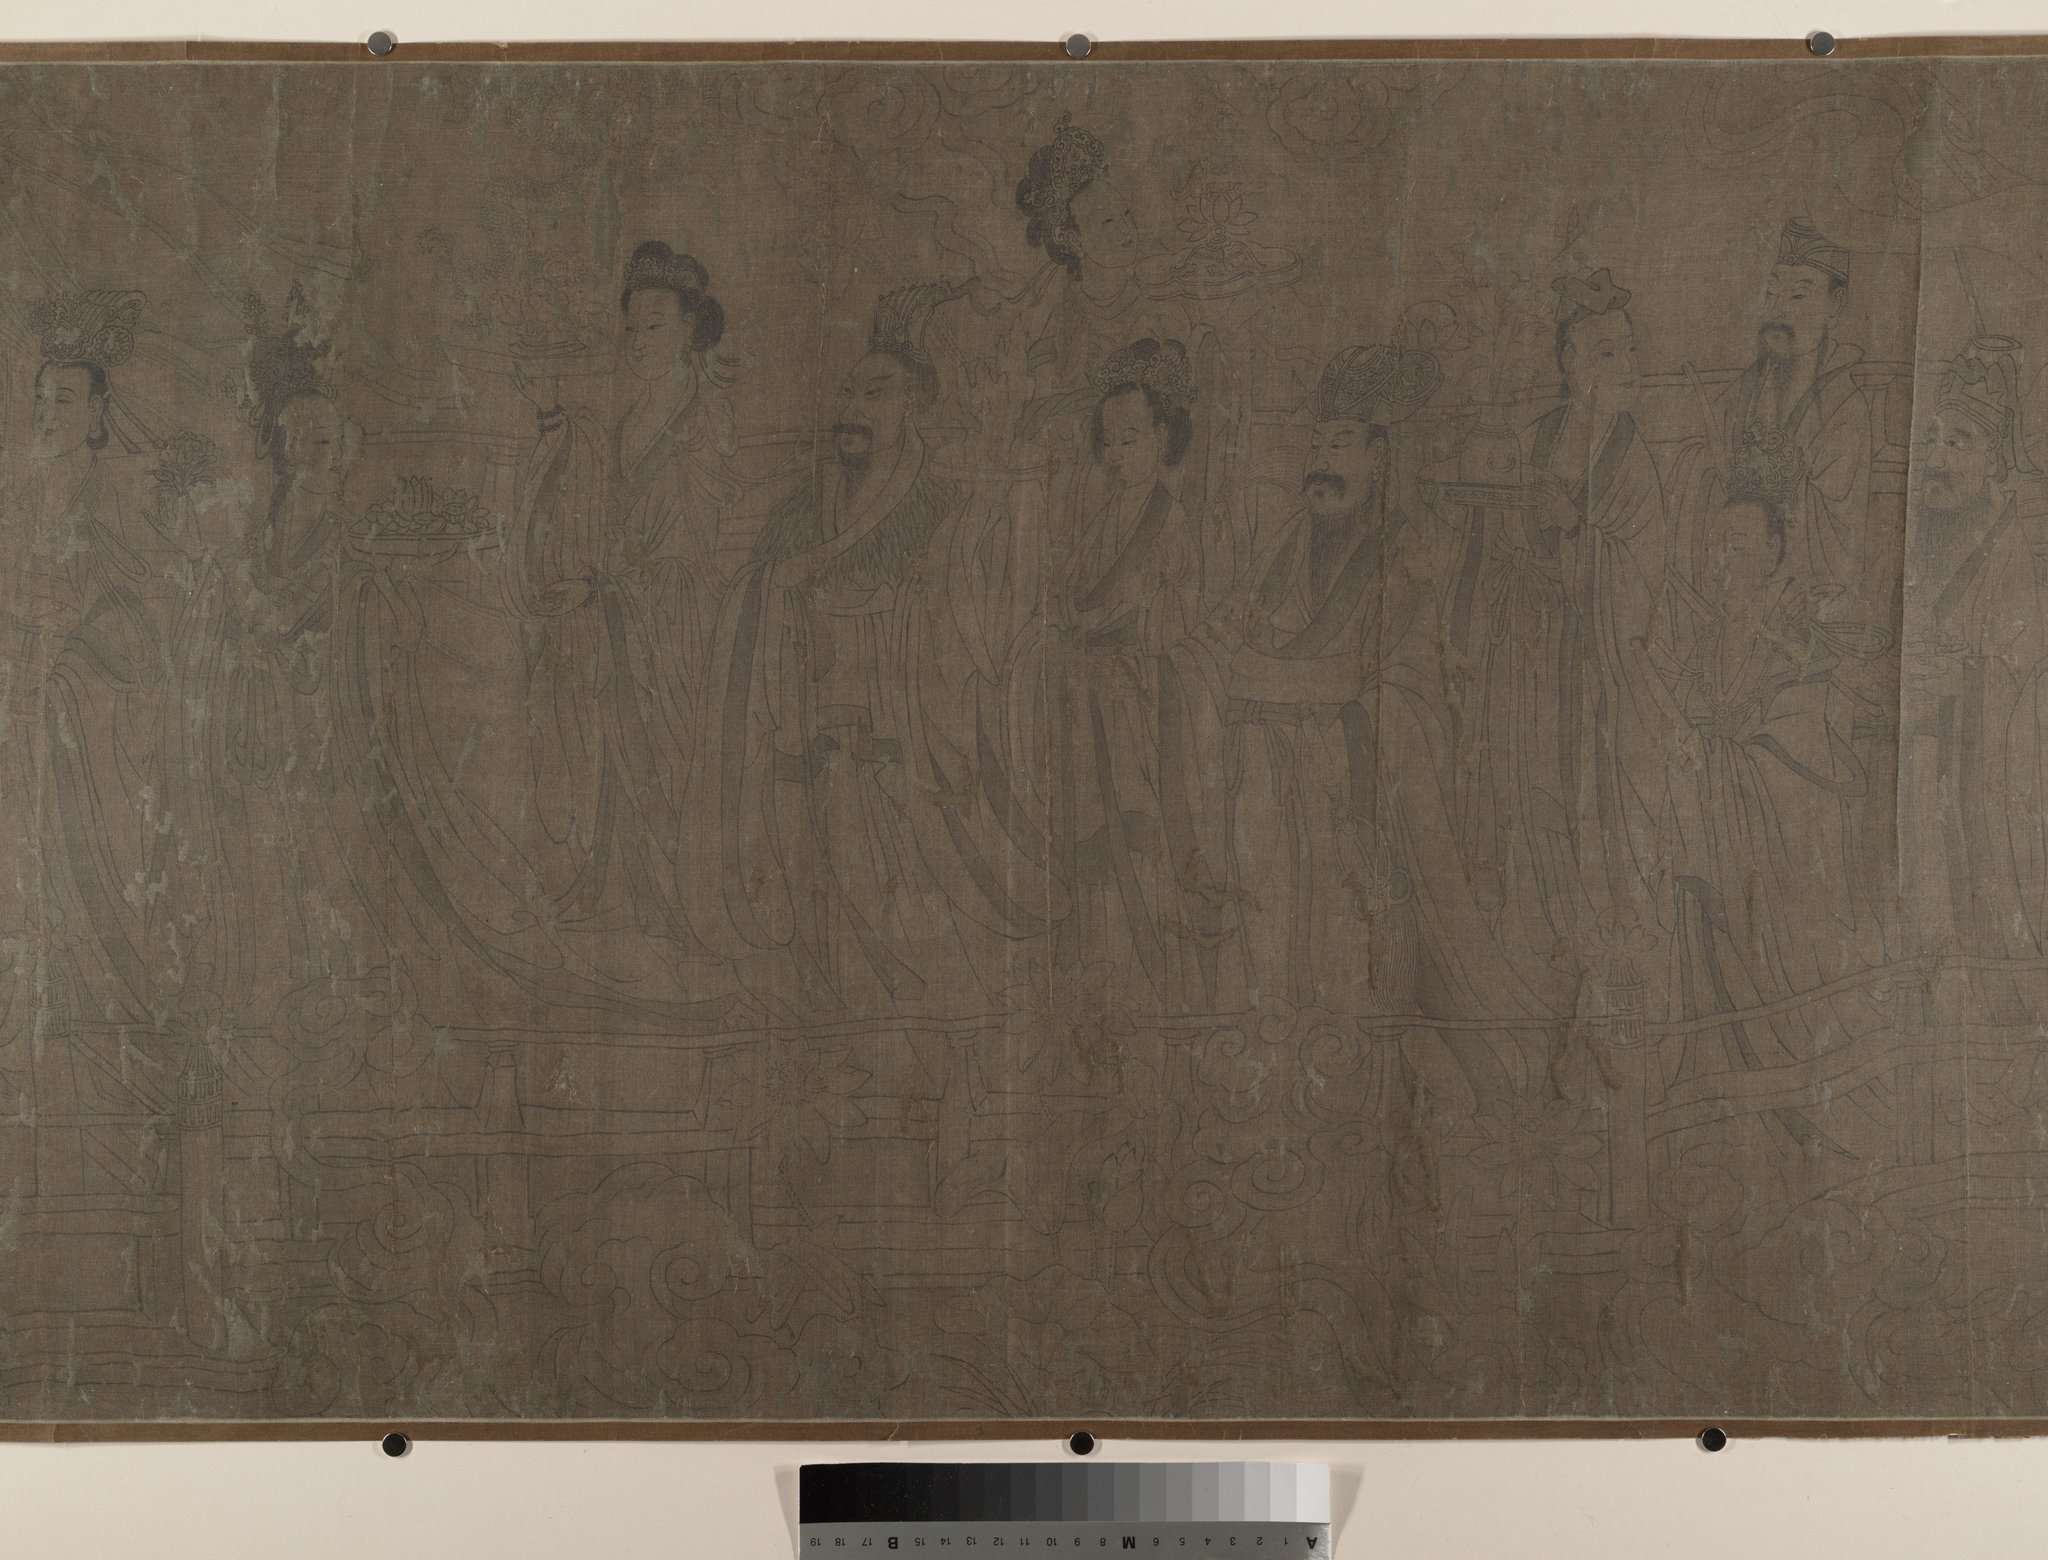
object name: handscroll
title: Five Rulers at New Year's Reception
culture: chinese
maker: unidentified artist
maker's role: artist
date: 1368-1911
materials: ink, silk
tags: men,women